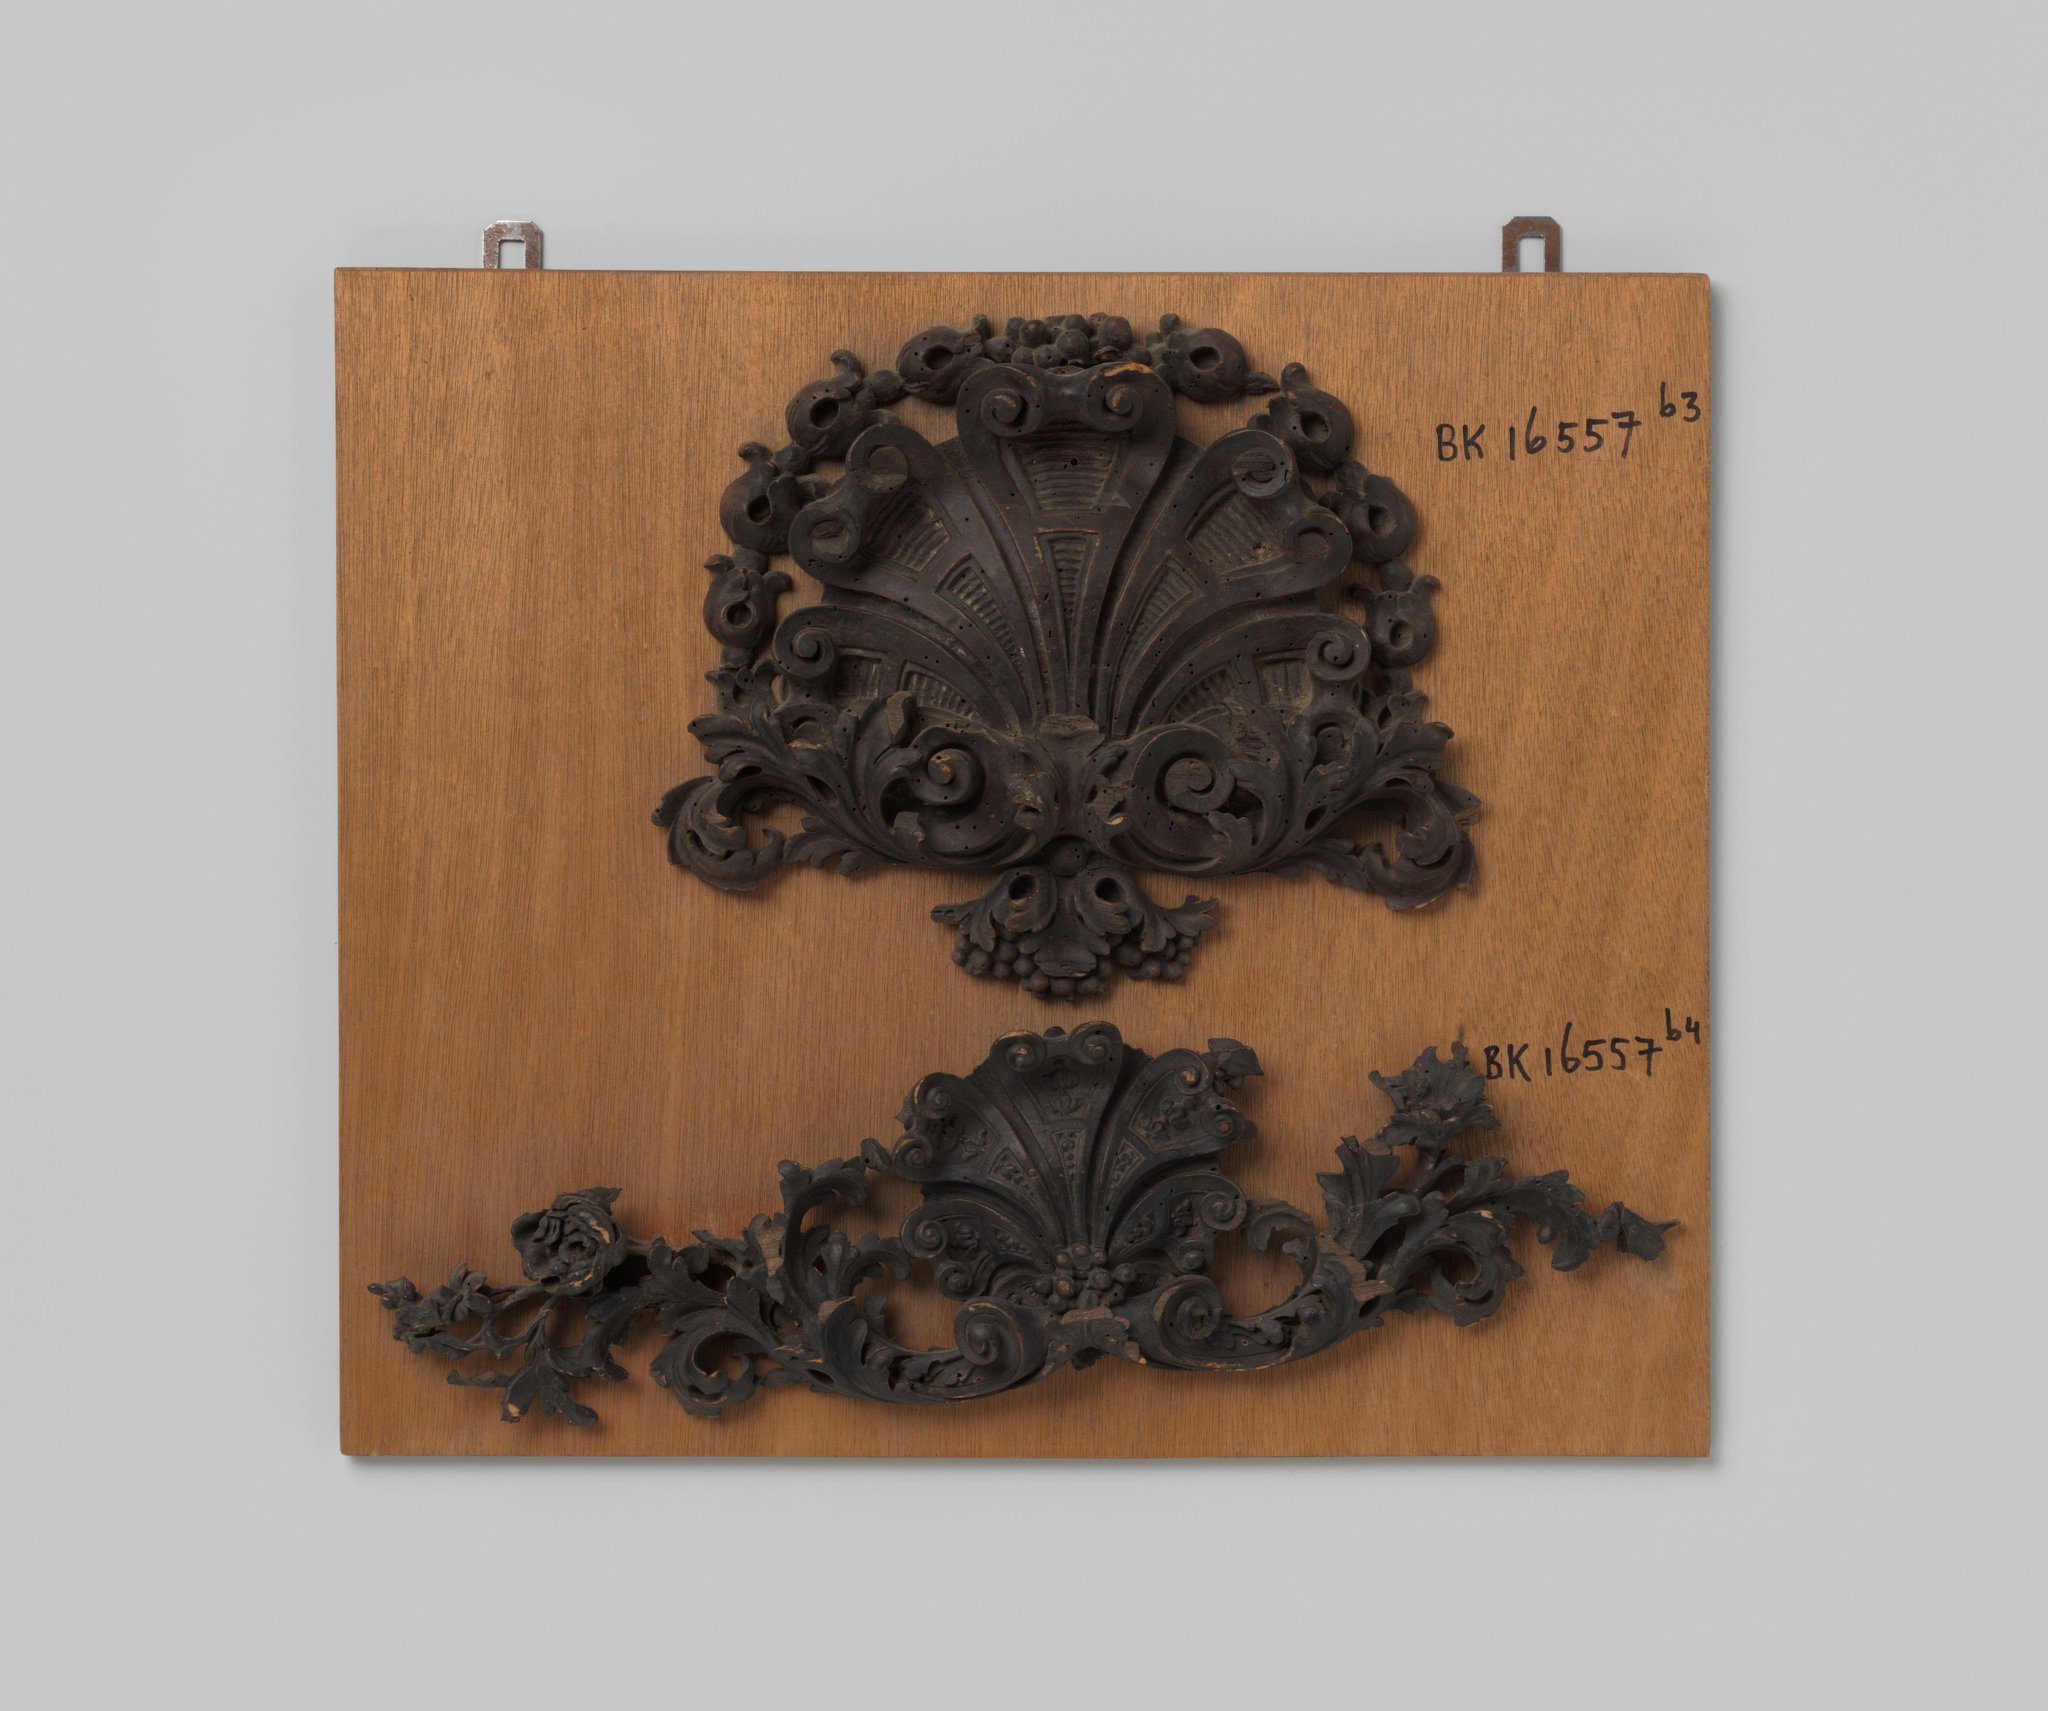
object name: fragment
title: Houten fragment, afkomstig uit Huis de Voorst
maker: Anonymous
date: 1700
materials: wood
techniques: stain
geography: northern netherlands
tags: huis de voorst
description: Houten fragment, versierd met snijwerk. Het fragment heeft in het midden een uitwaaierend motief, opgebouwd uit tegengestelde S-voluten, van onderen bijeengehouden door een vruchtenmotief; hieruit ontspruiten naar links en rechts weelderige bladranken.